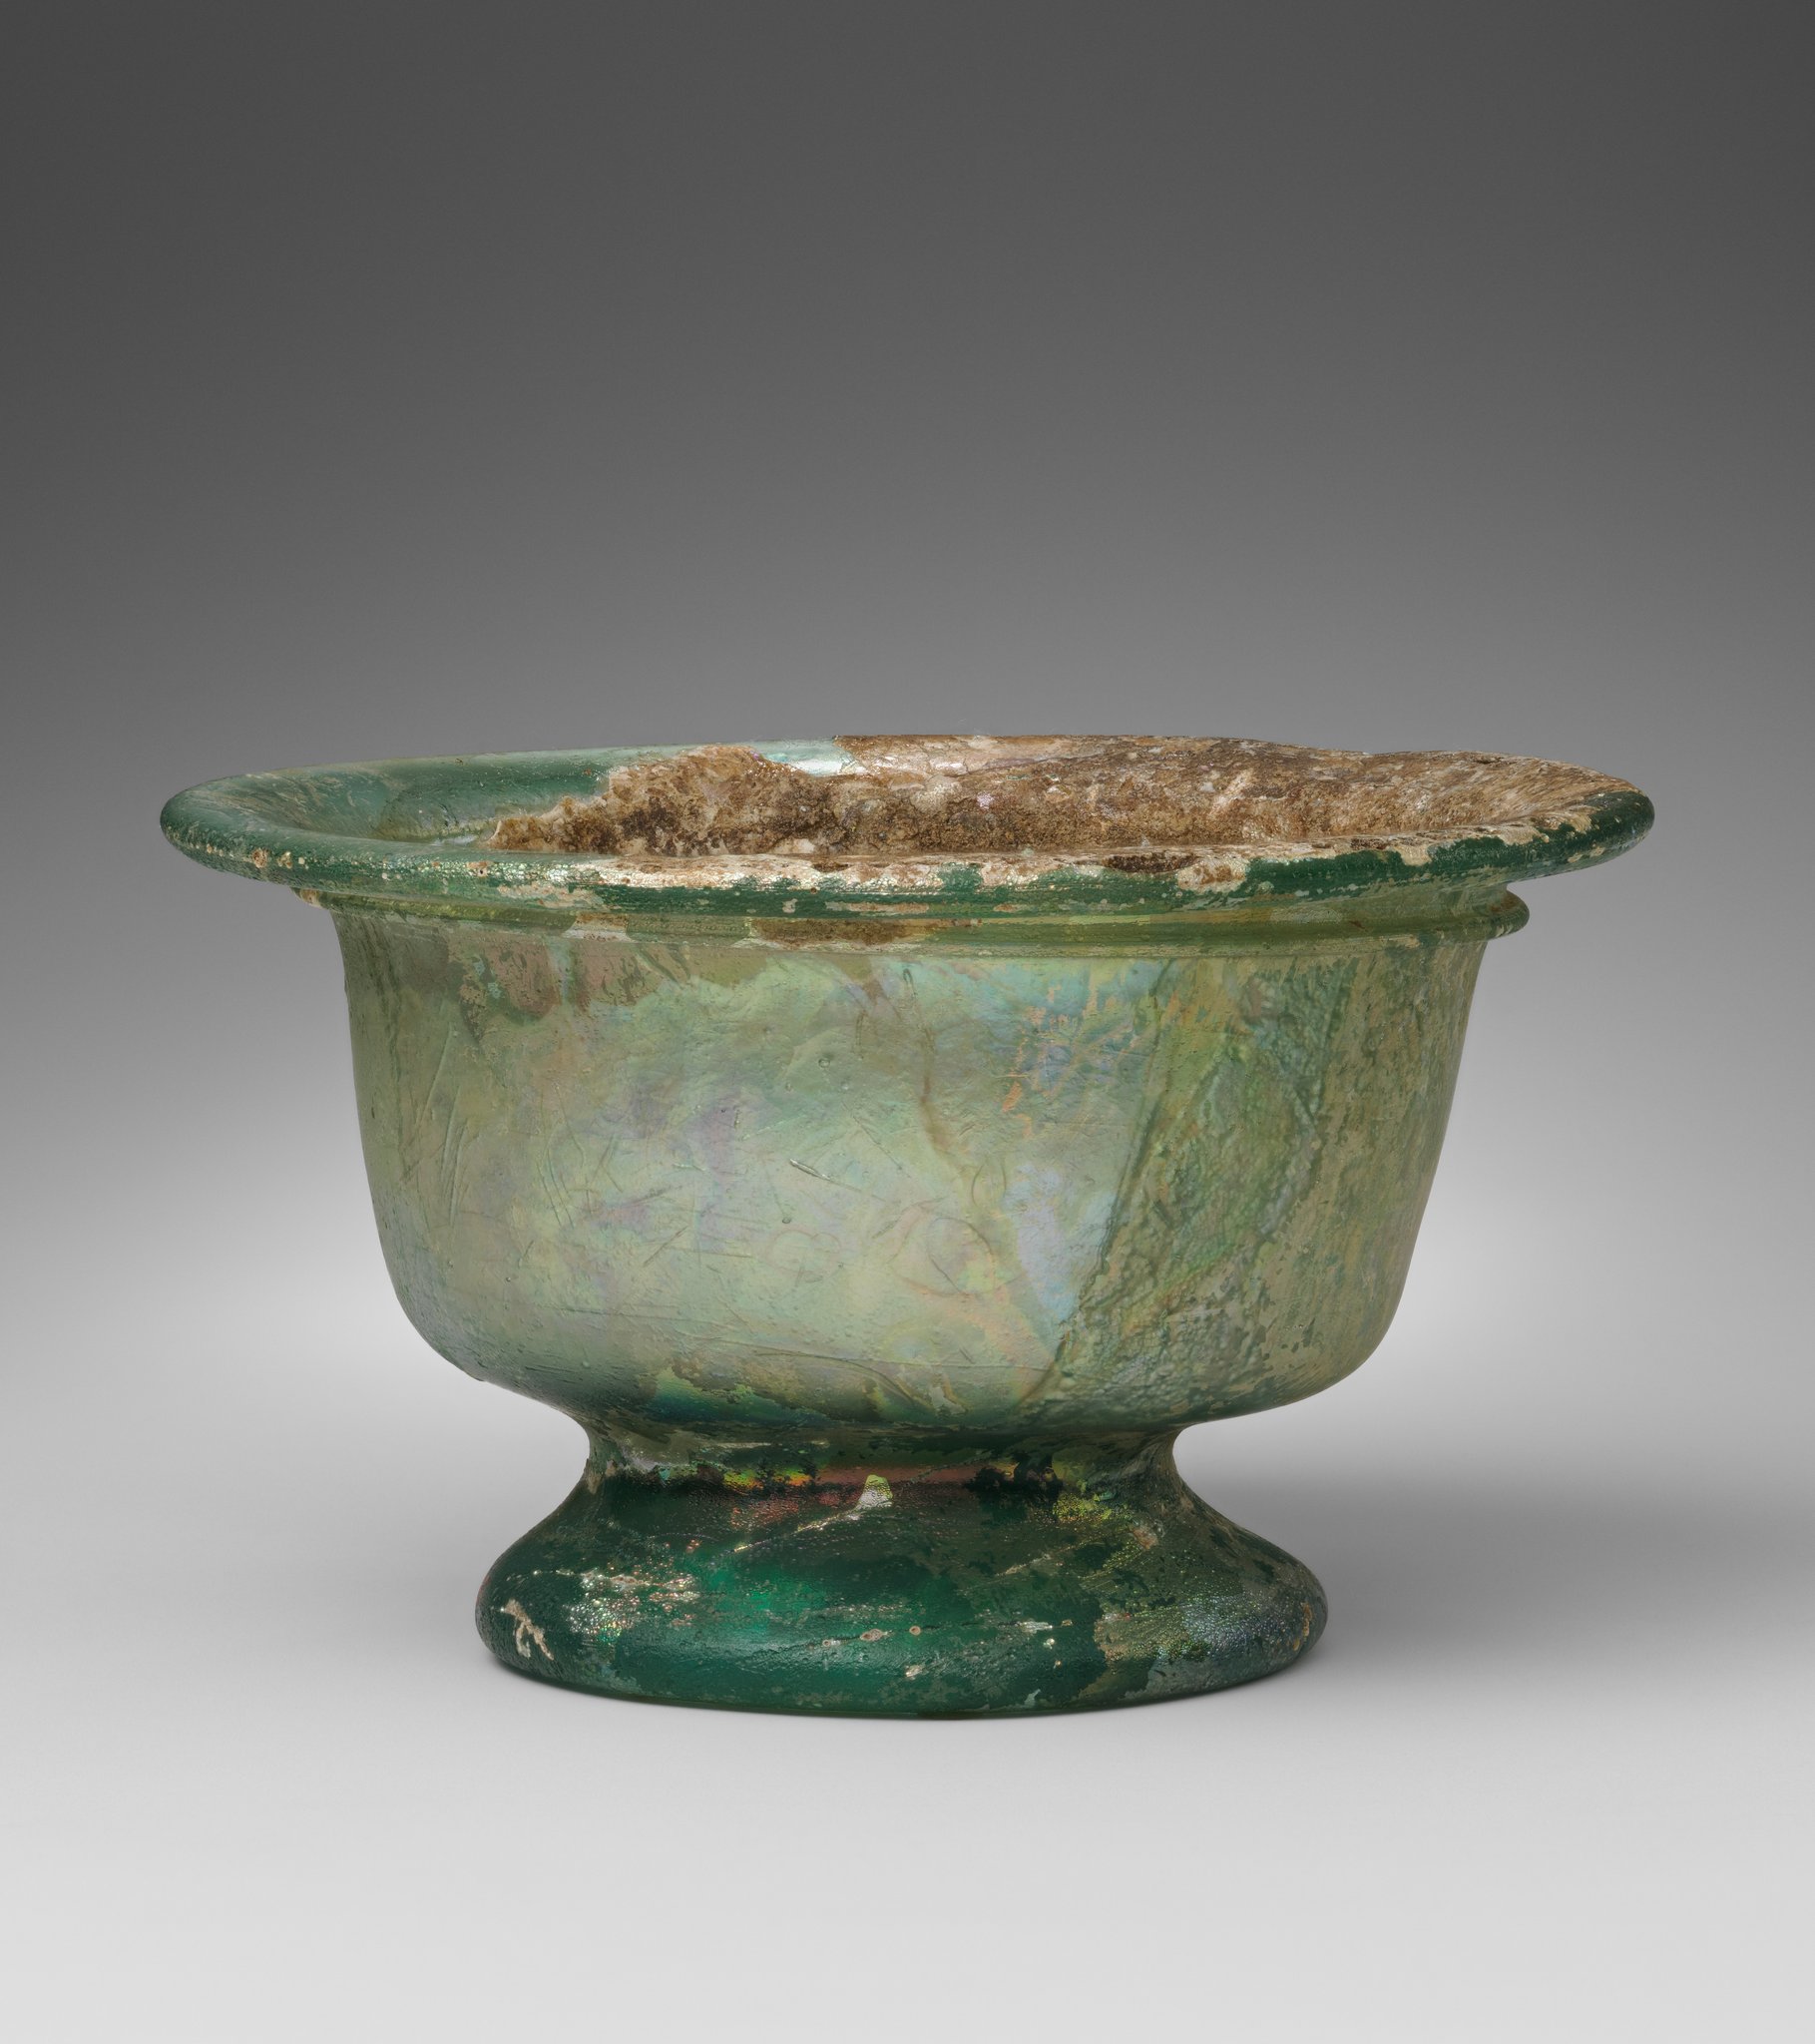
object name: footed bowl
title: Glass bowl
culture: roman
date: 201-400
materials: glass